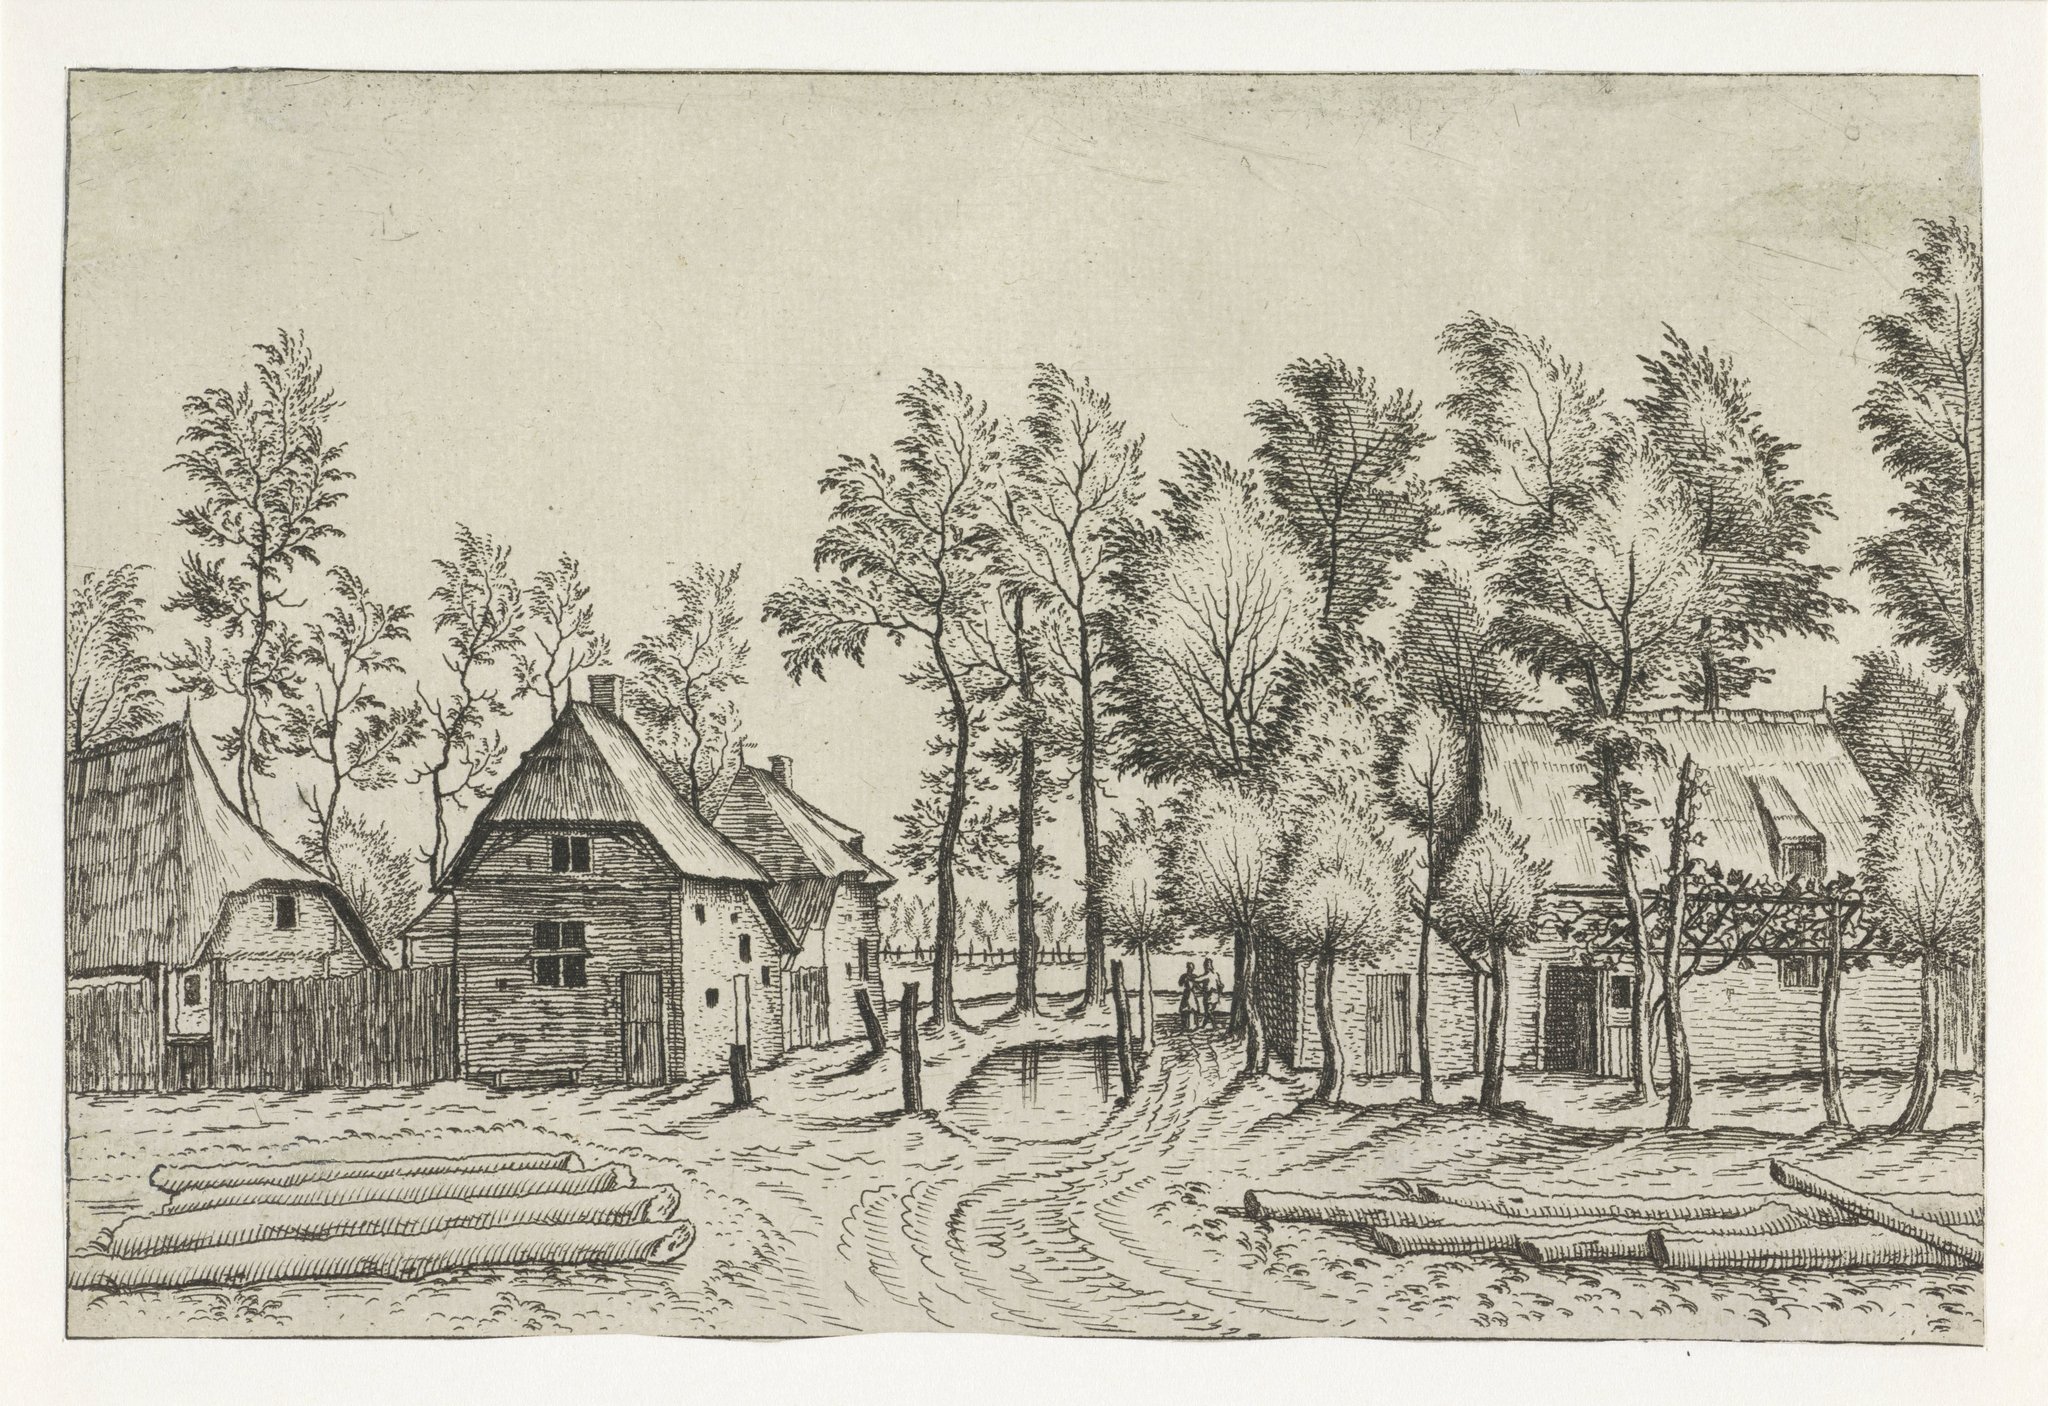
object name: print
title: Dorpsstraat met boomstammen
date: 1559-1561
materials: paper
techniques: etching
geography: antwerp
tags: public road in village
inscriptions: collector's mark: Lugt 2760, collector's mark: Lugt 2228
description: Gezicht op een dorpsstraat met boomstammen op de voorgrond.